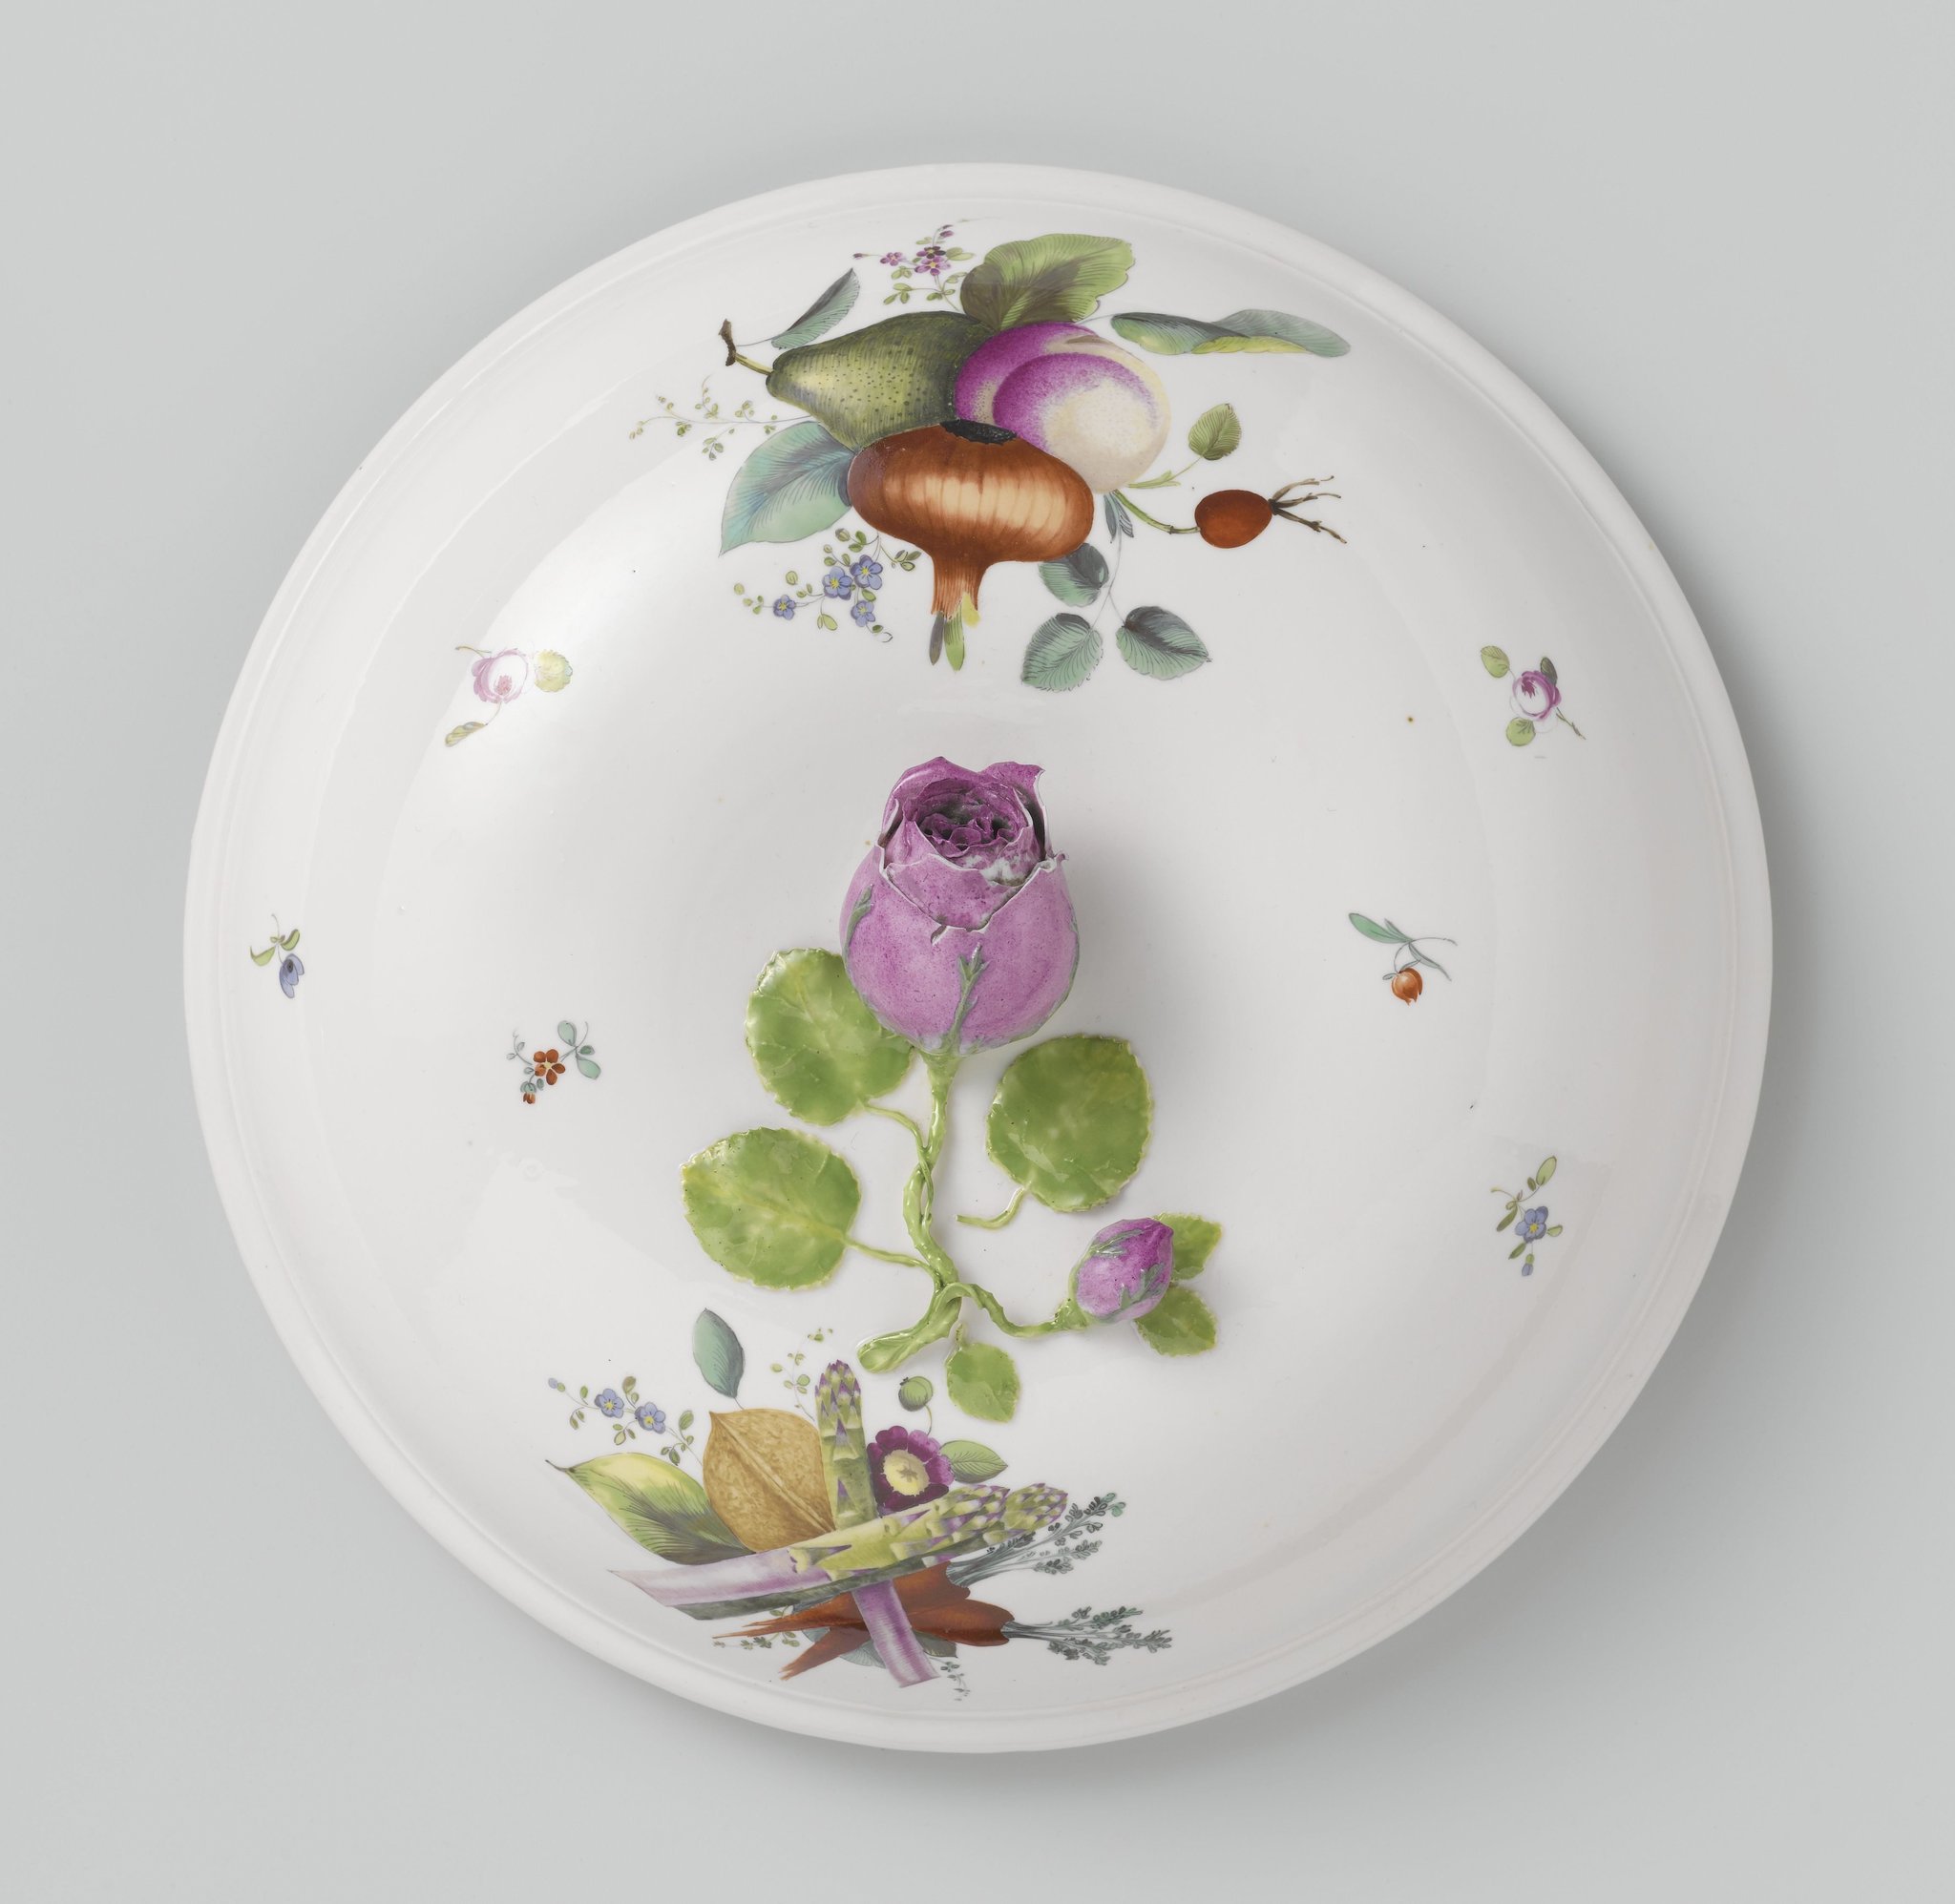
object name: lid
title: Deksel van punchkom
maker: Anonymous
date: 1777-1790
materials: porcelain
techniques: painted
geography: the hague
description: De deksel van de punchkom is veelkleurig beschilderd met groenten, vruchten en bloemen.